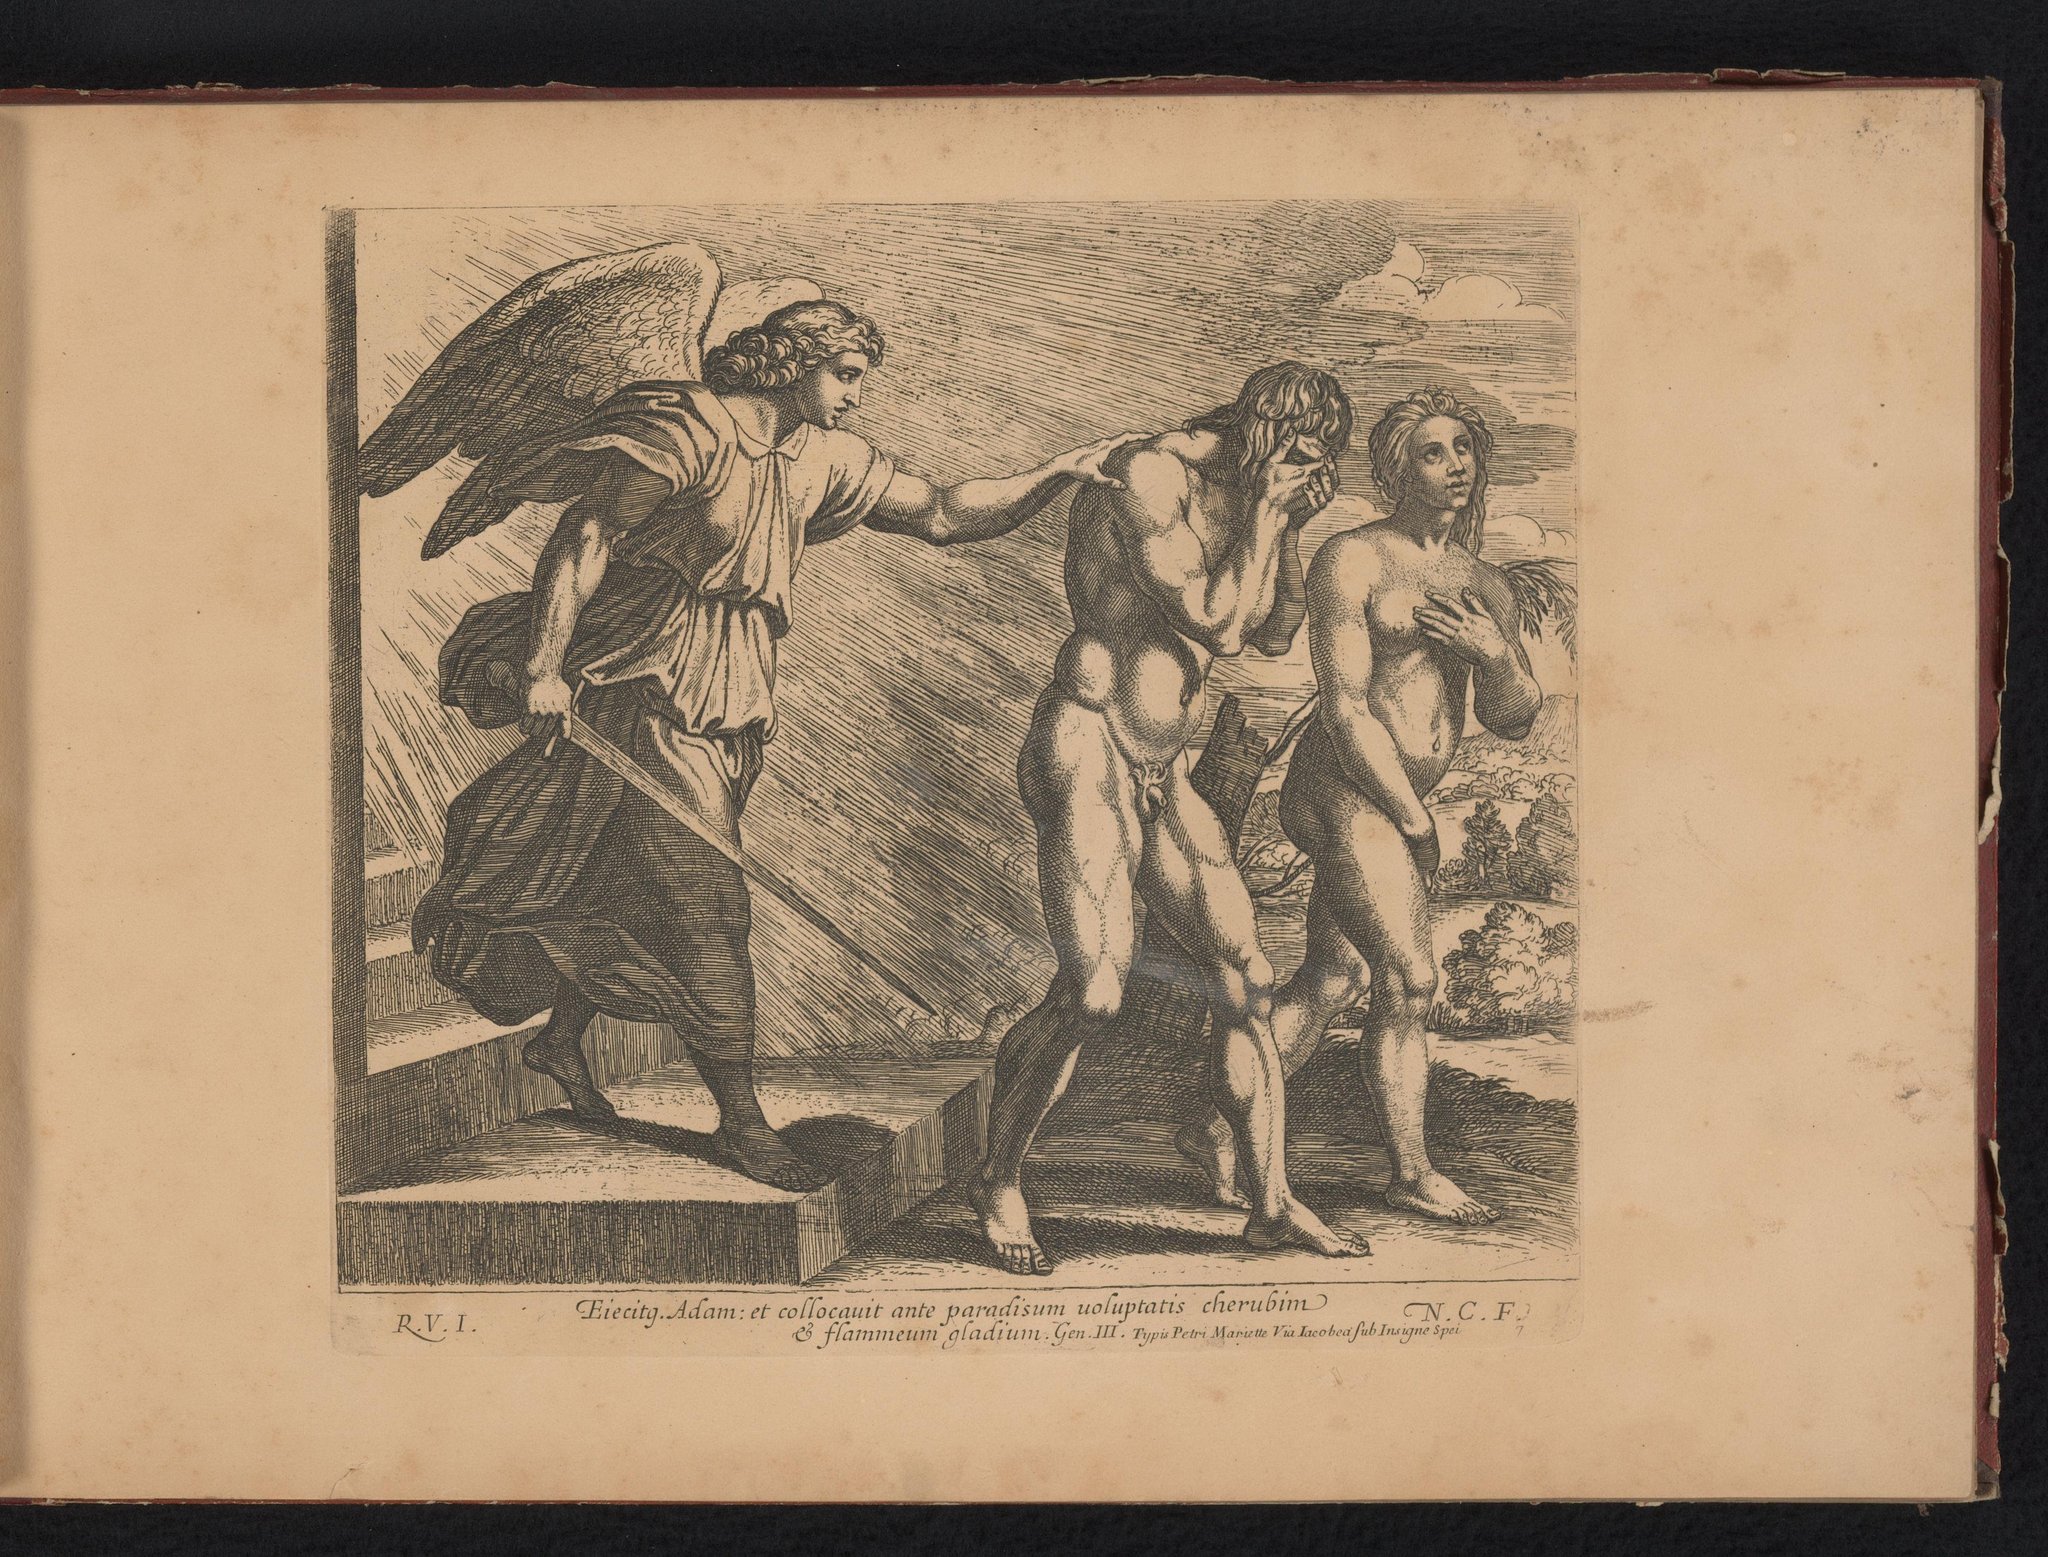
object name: album leaf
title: Rafaël Bijbel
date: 1649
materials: paper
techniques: etching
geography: paris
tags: eve offers the fruit to adam, adam and eve holding (and possibly eating) the fruit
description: Deze prent maakt deel uit van een album.